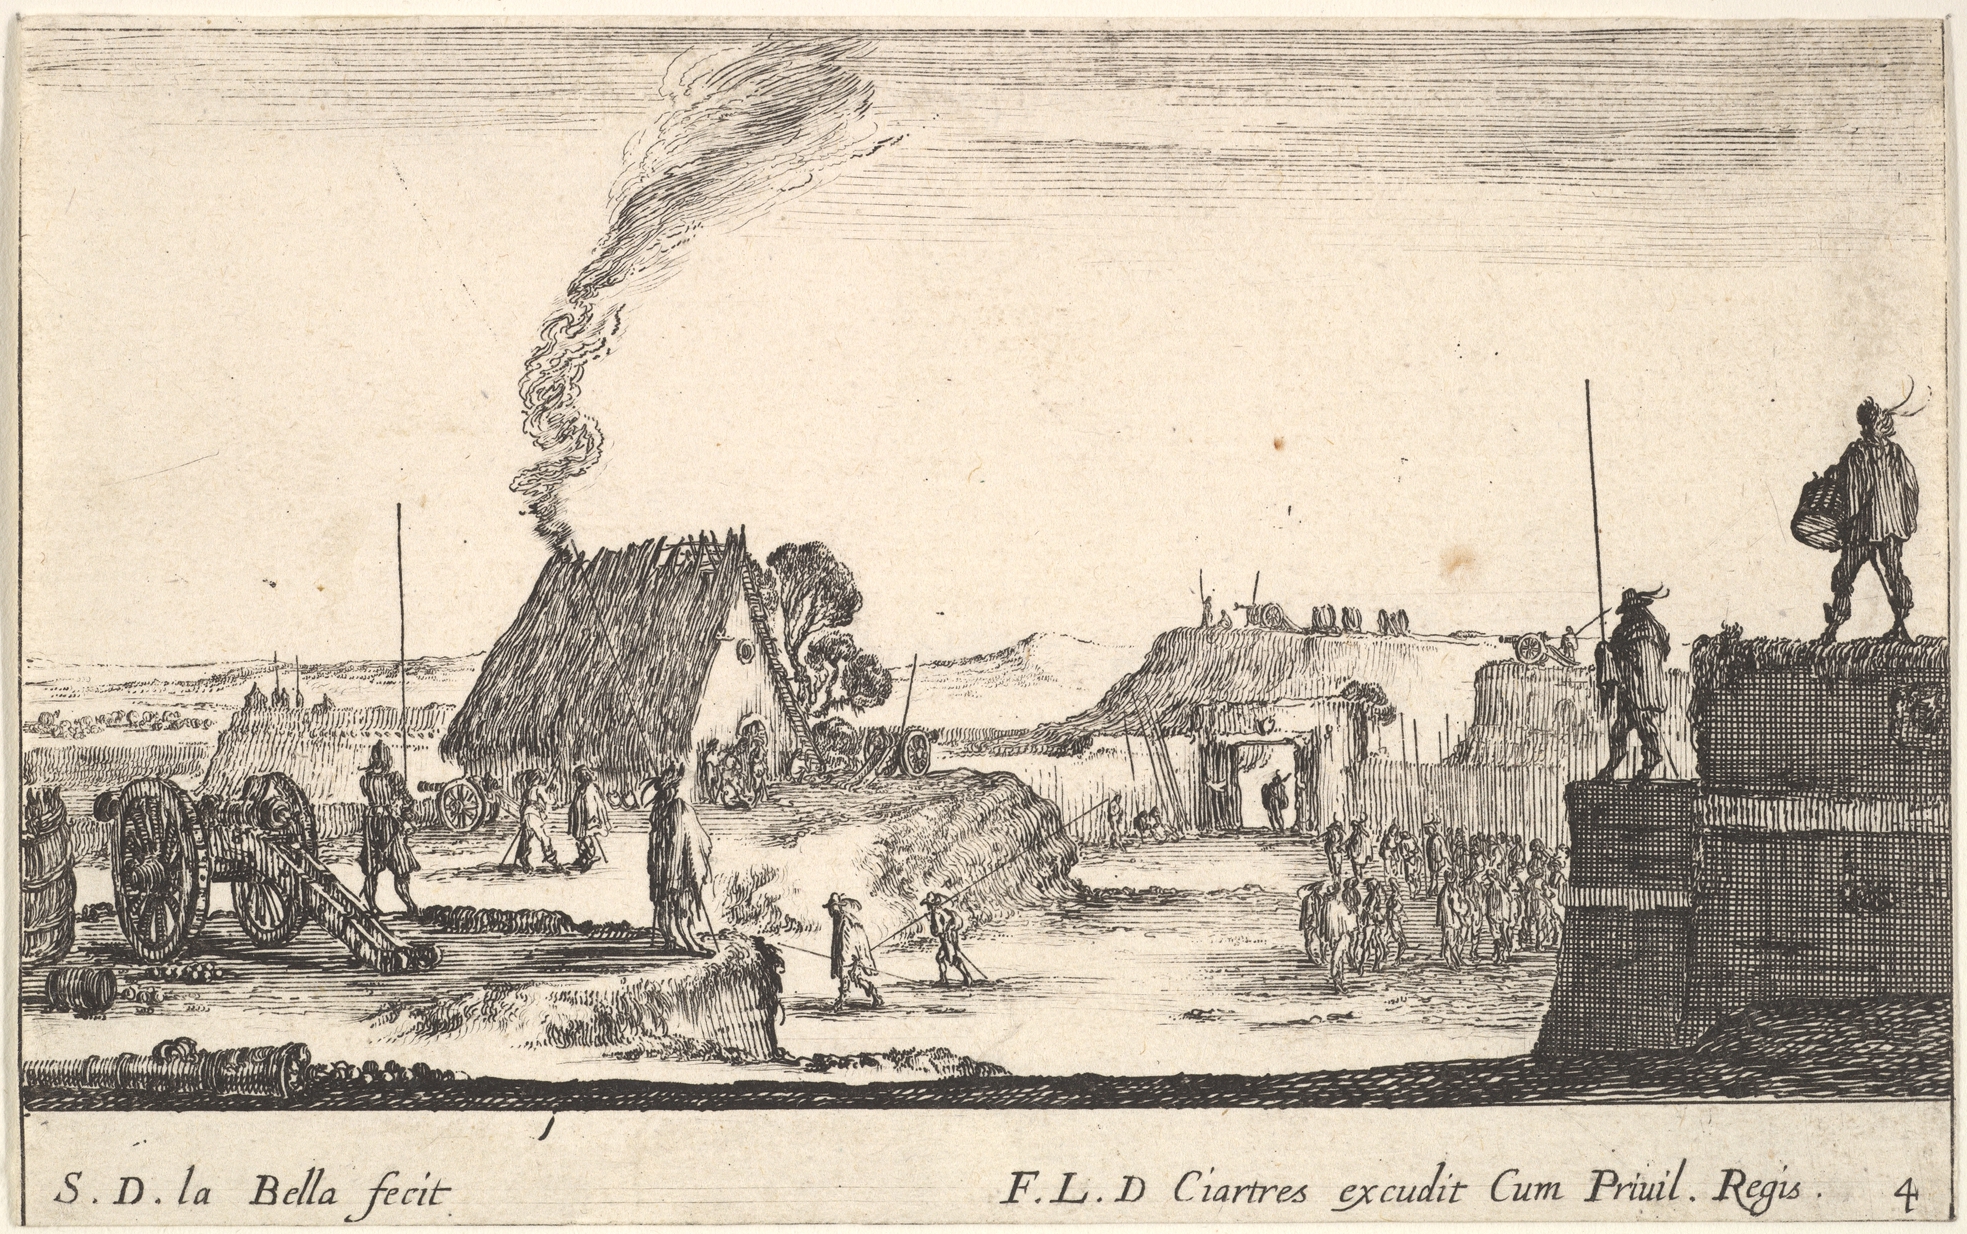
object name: print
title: Plate 4: A military encampment with a soldier standing on a parapet to the right beating a drum, from "Various Military Caprices" (Varii capricci militari)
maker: stefano della bella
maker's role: artist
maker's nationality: italian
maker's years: 1610-1664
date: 1641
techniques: etching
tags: houses,military,soldiers,men,drums